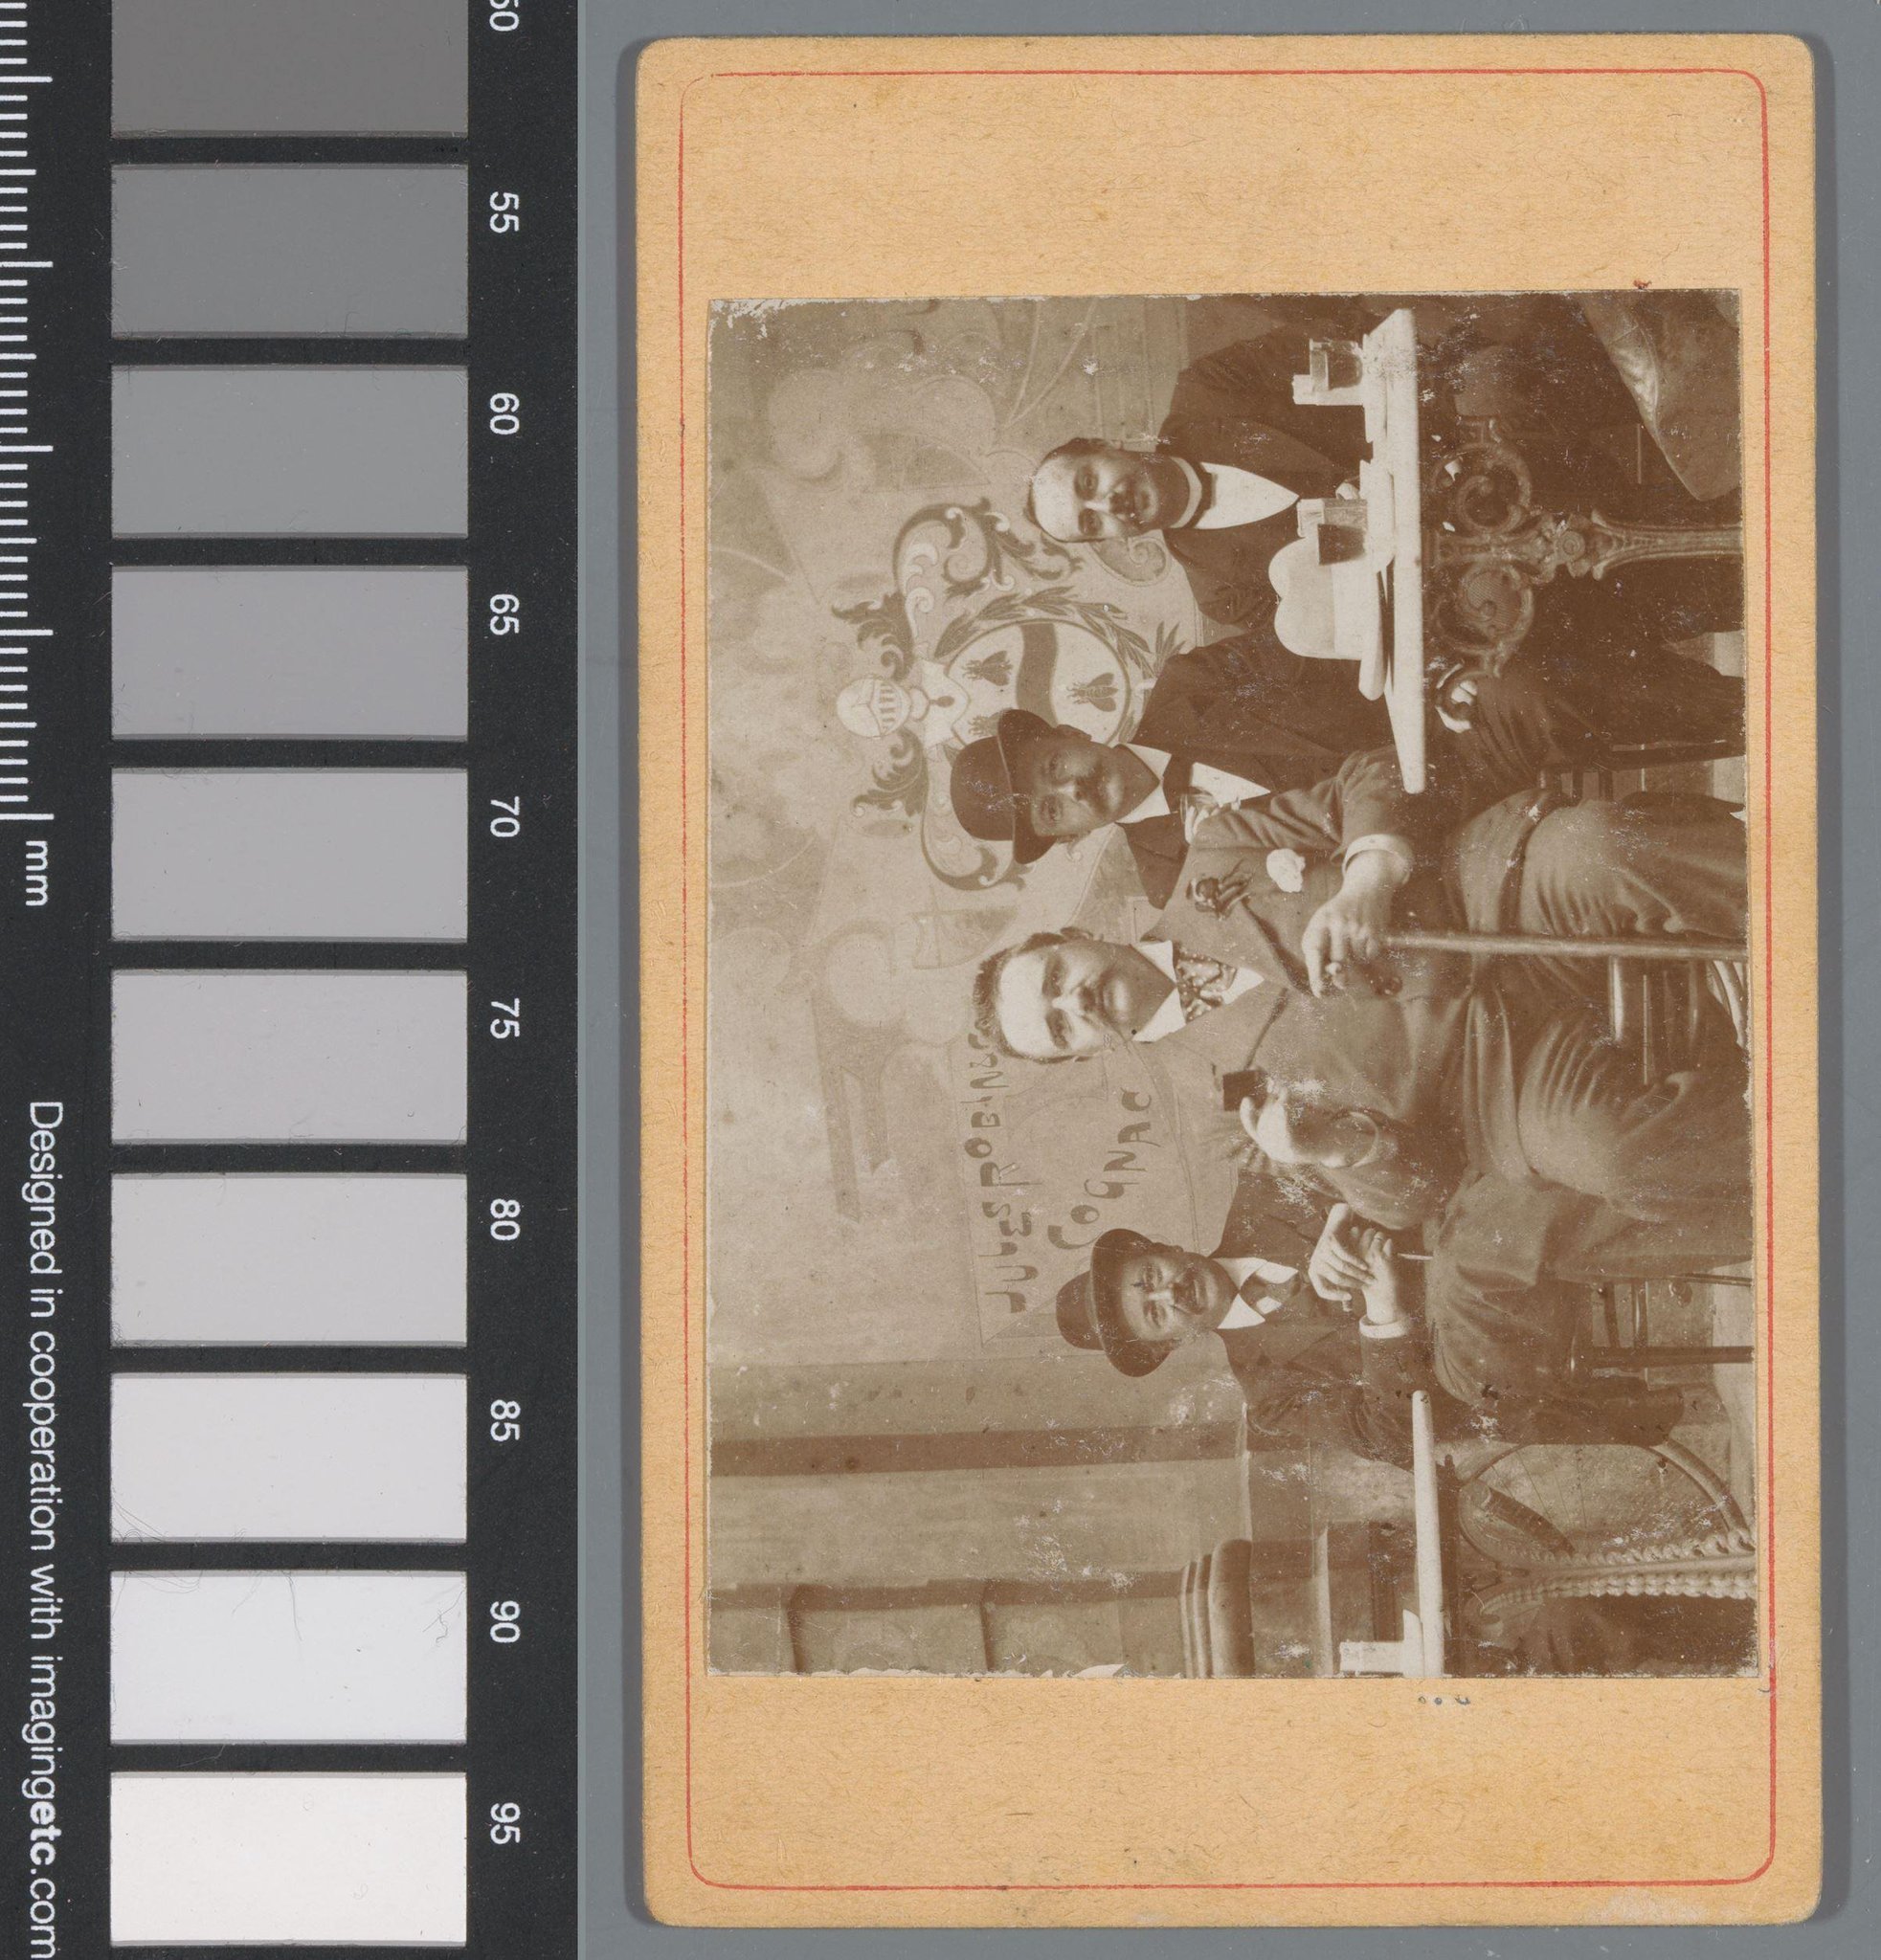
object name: photograph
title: Groepsportret met vier mannen op een caféterras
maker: Anonymous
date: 1900-1914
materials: paper, cardboard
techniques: collodion silver print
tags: pavement, terrace in front of inn or restaurant, anonymous historical persons portrayed in a group, in a group-portrait